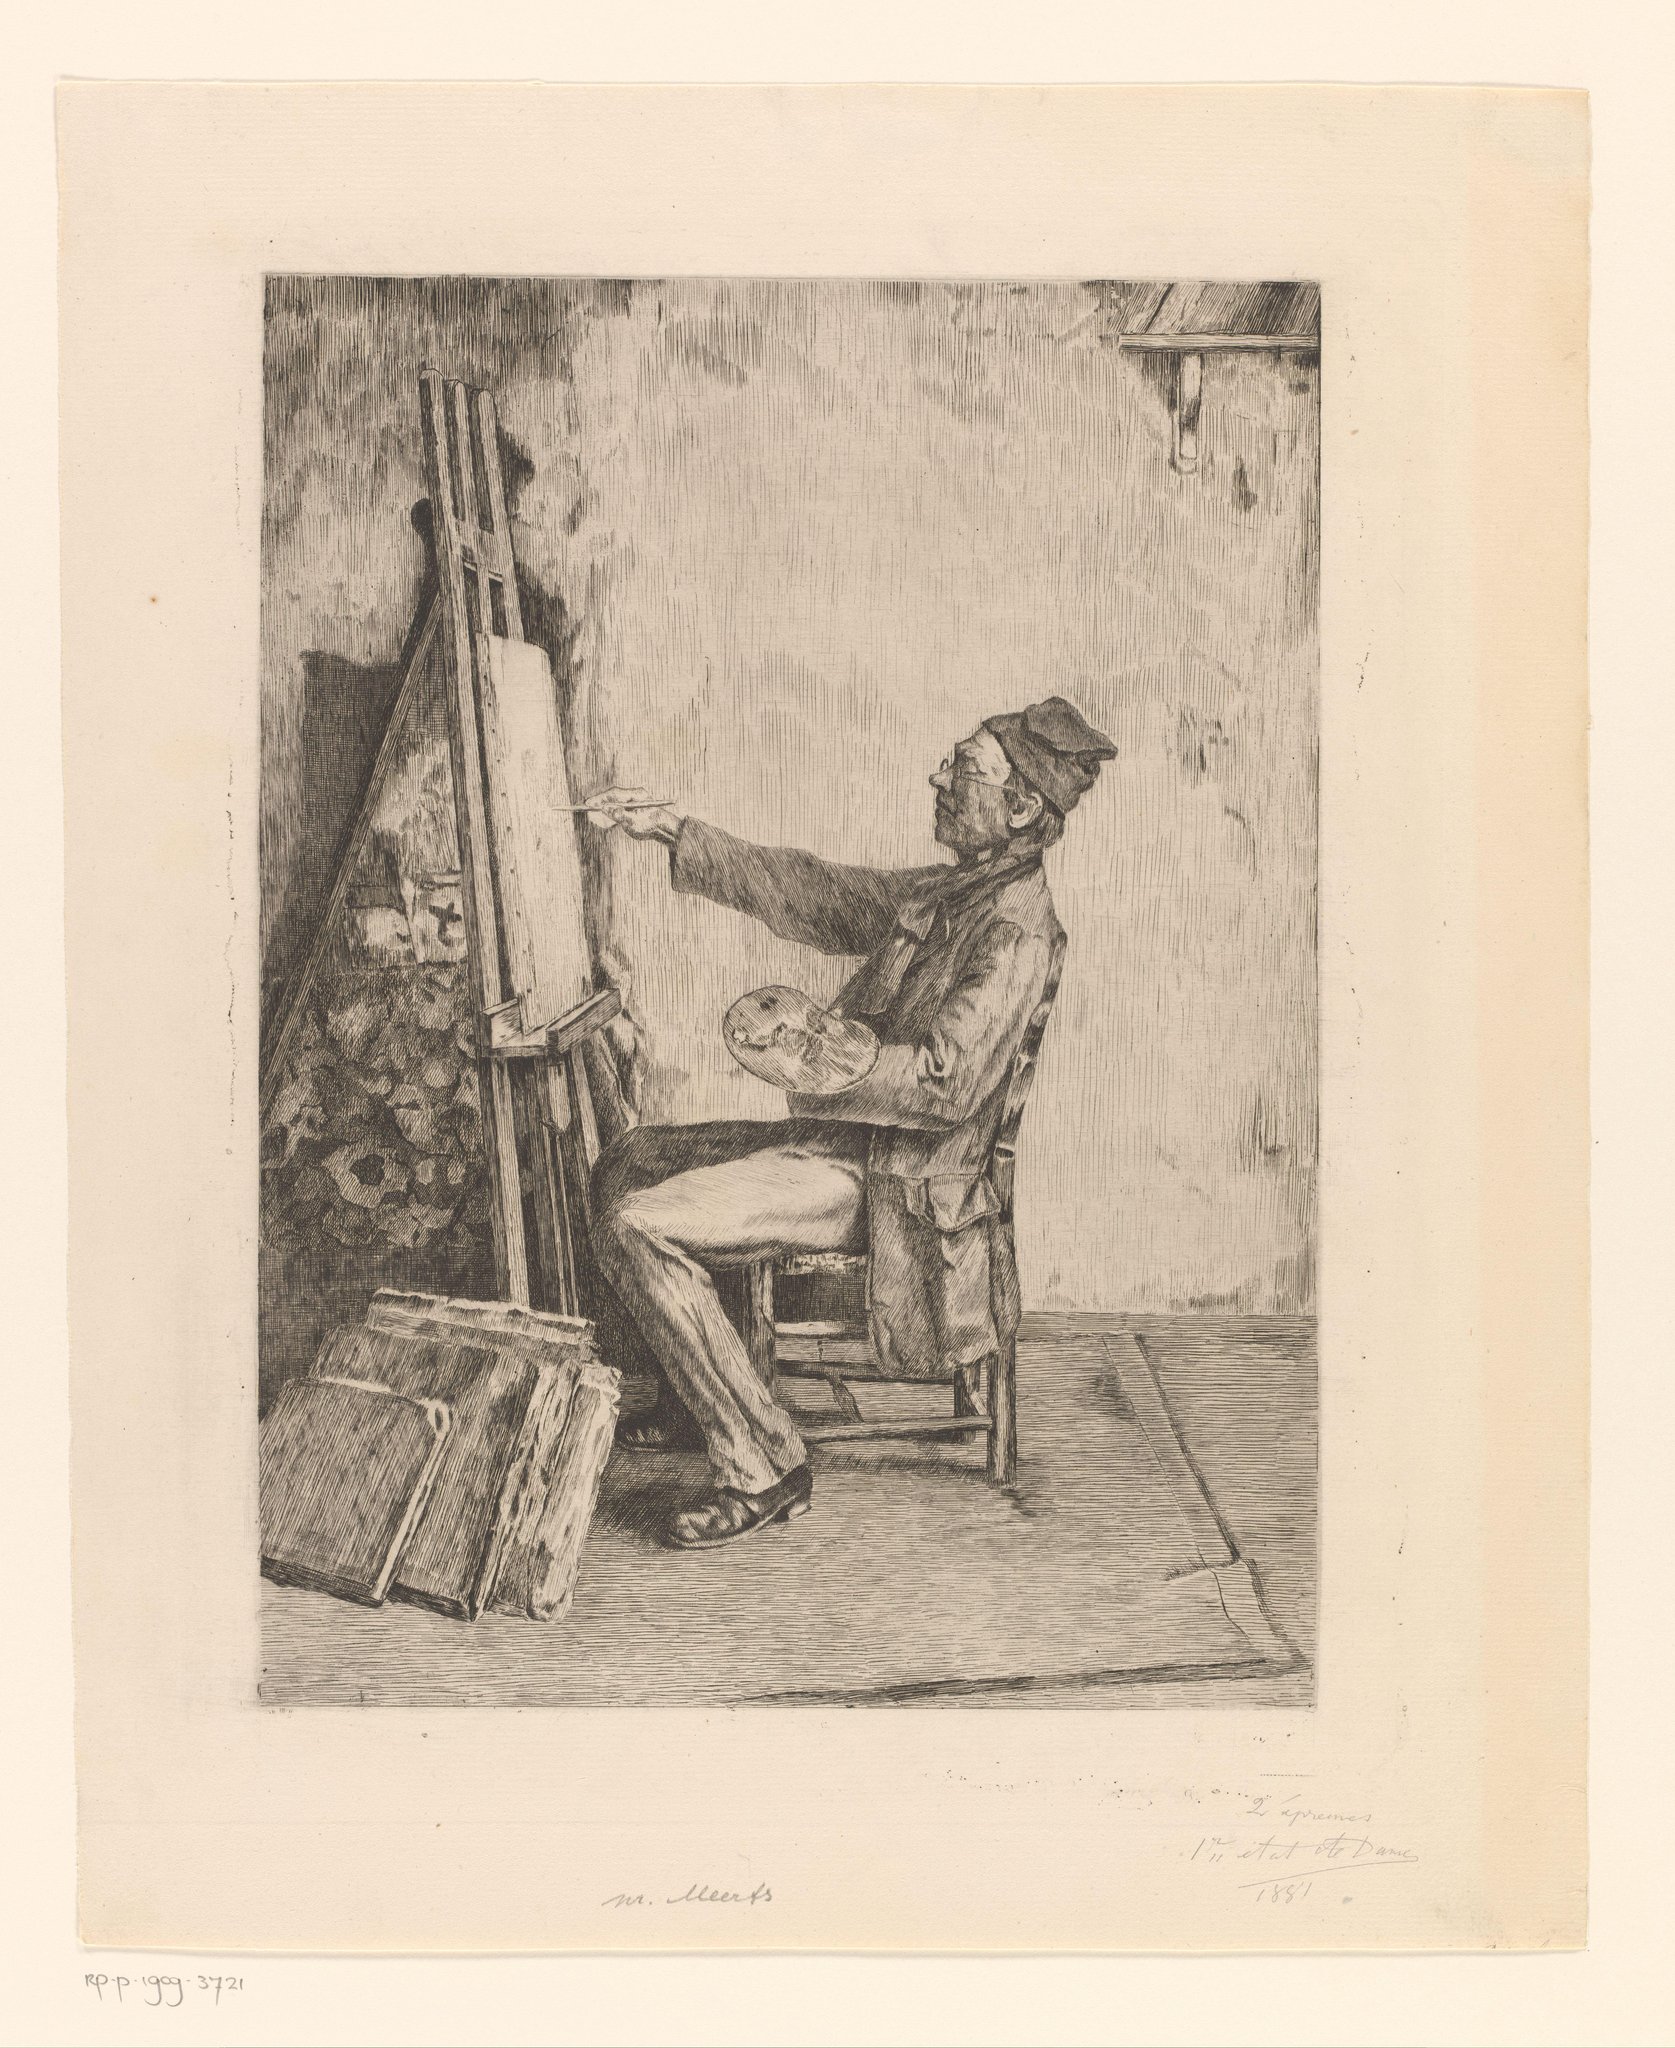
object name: print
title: Portret van Frans Meerts aan zijn ezel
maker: auguste danse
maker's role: print maker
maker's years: 1829-1929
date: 1881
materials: paper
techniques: drypoint, etching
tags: ghent, brussels, painter, frans meerts, painter at work, in his studio, portrait, self-portrait of artist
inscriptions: collector's mark: Lugt 2228, annotation: ‘2 épreuves 1er etat’